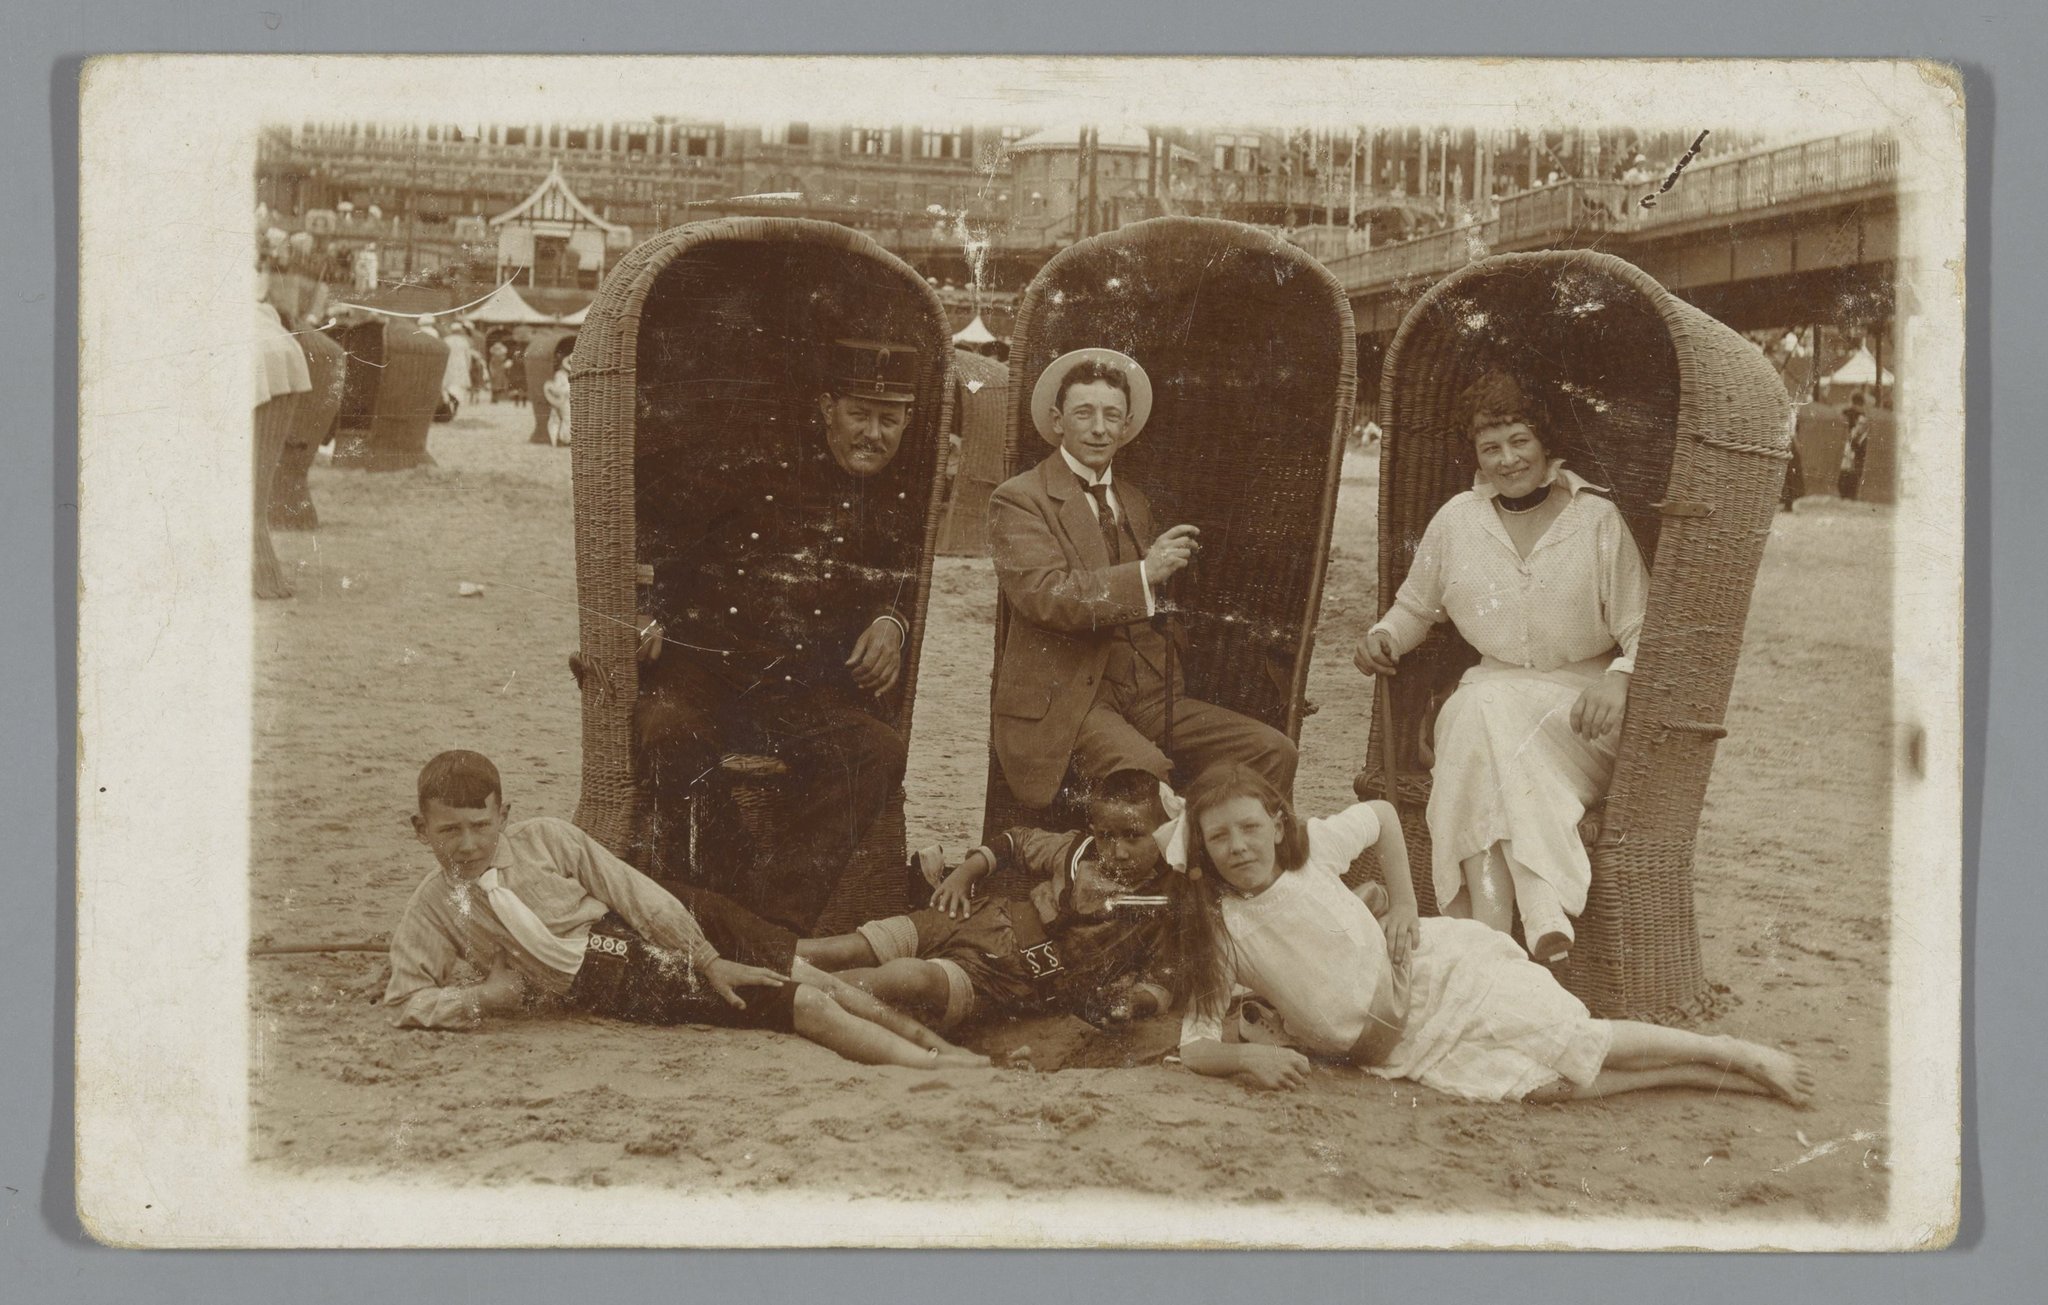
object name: photograph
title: Groepsportret van een onbekende familie op het strand (vermoedelijk) te Scheveningen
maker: Anonymous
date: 1910-1935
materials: photographic support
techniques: collodion silver print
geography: scheveningen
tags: beach (as place of recreation), family relationships (first, second, third and fourth degree), generations, chair